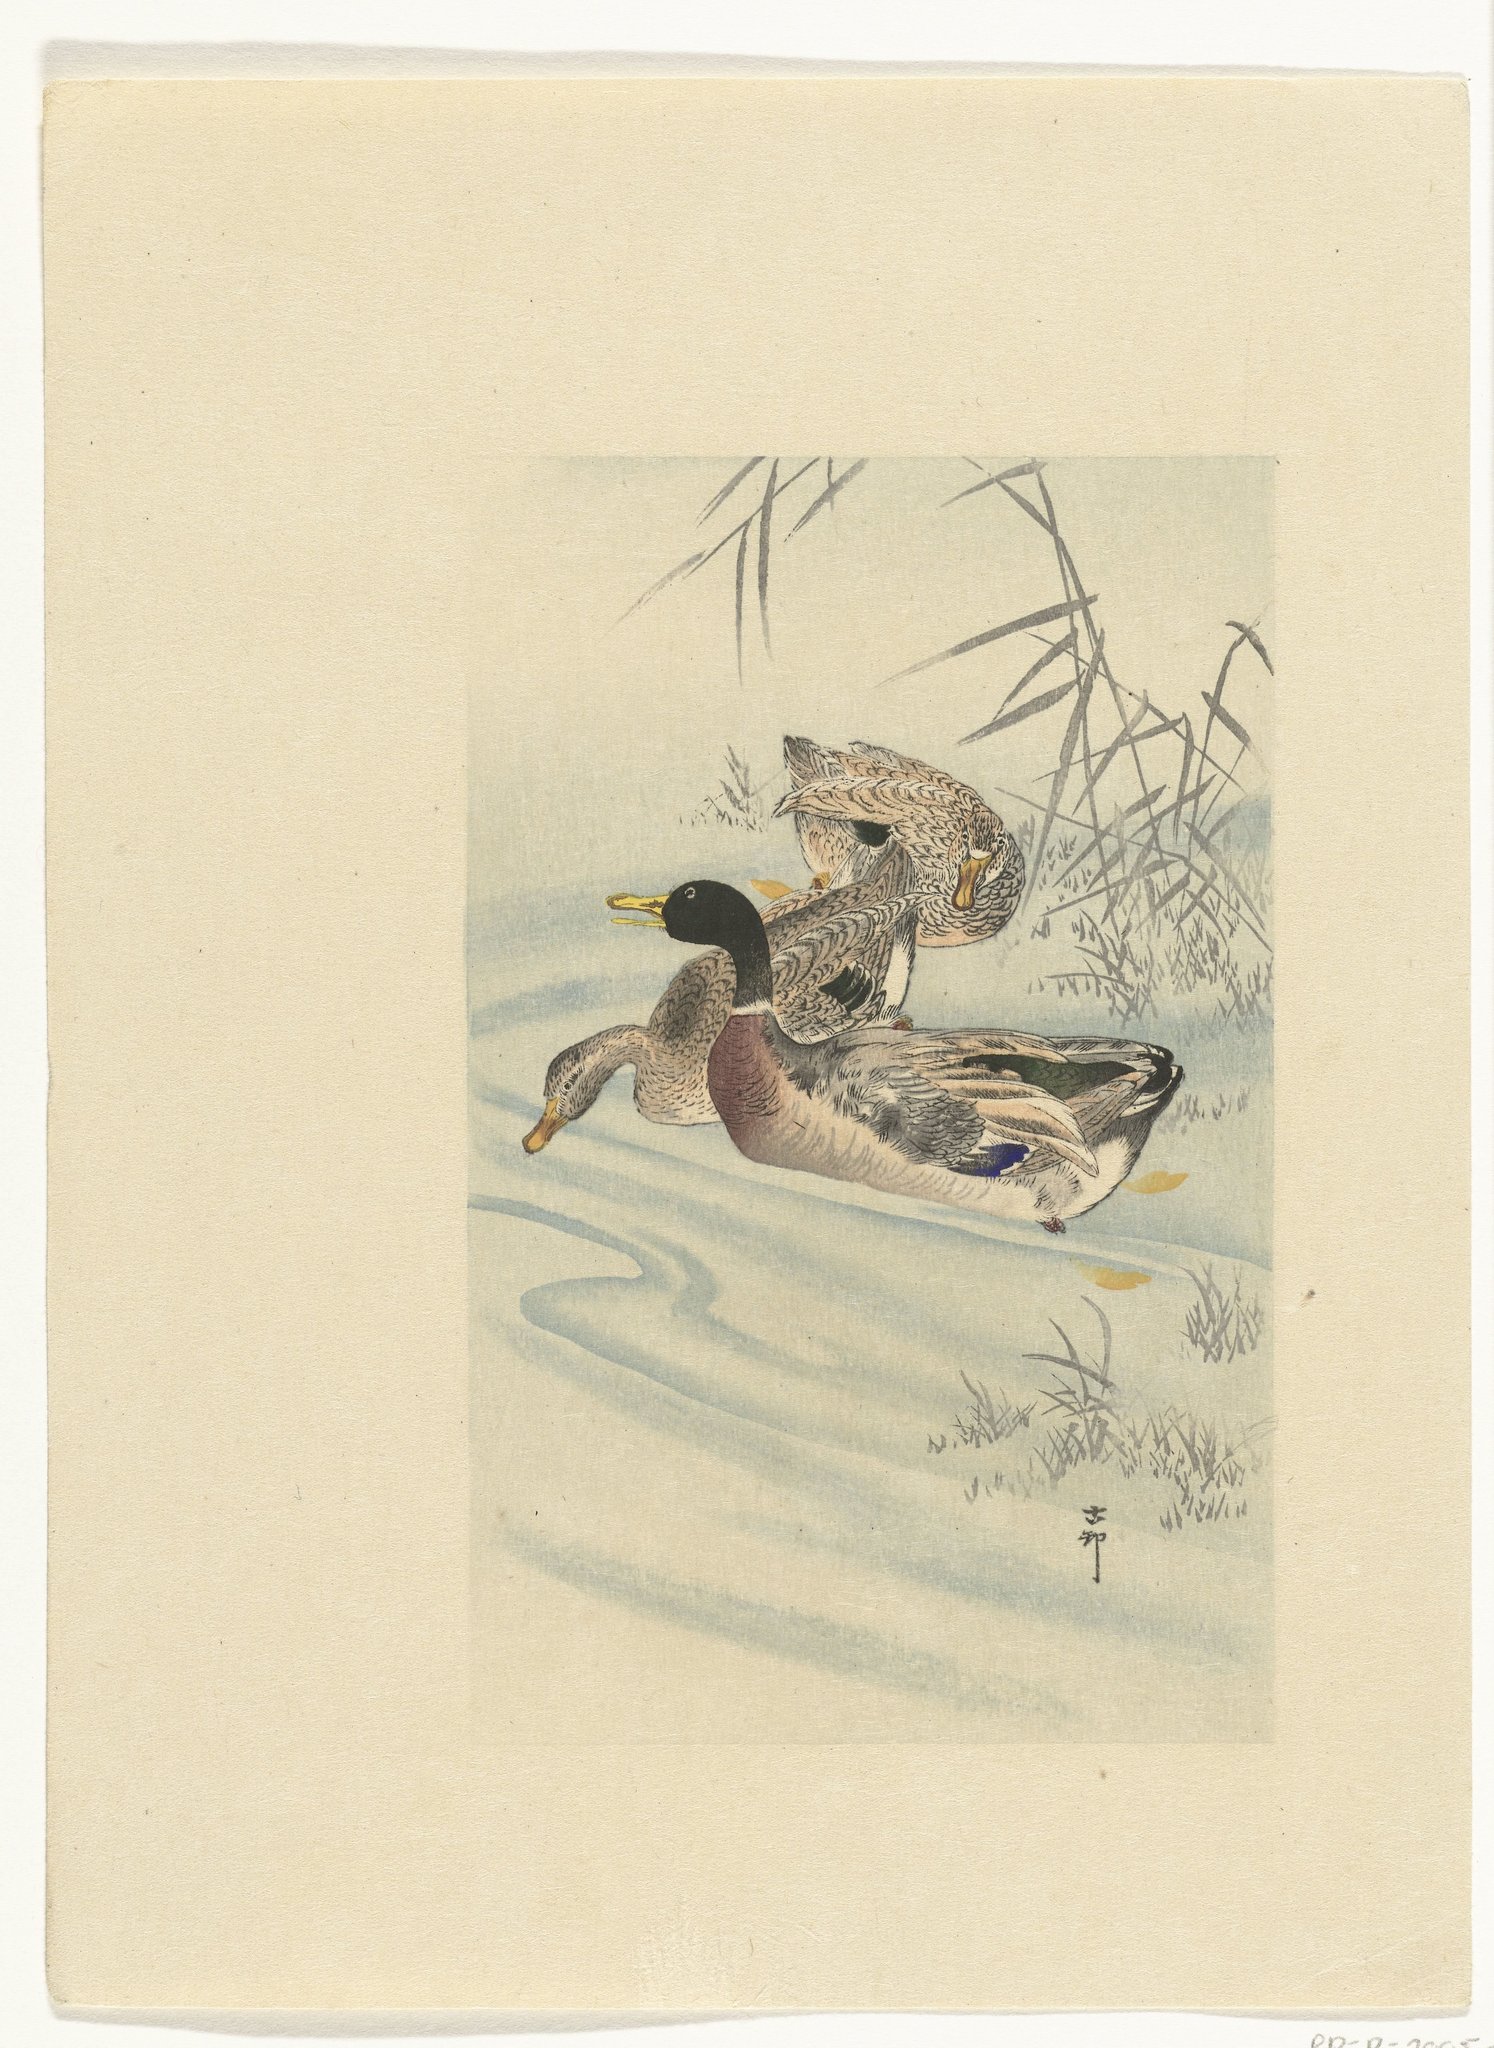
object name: print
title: Drie eenden in ondiep water met riet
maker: ohara koson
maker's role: print maker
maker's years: 1877-1945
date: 1900-1930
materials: paper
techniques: blind stamped, woodcut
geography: tokyo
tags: water course, water-birds: duck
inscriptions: collector's mark: Lugt 2228